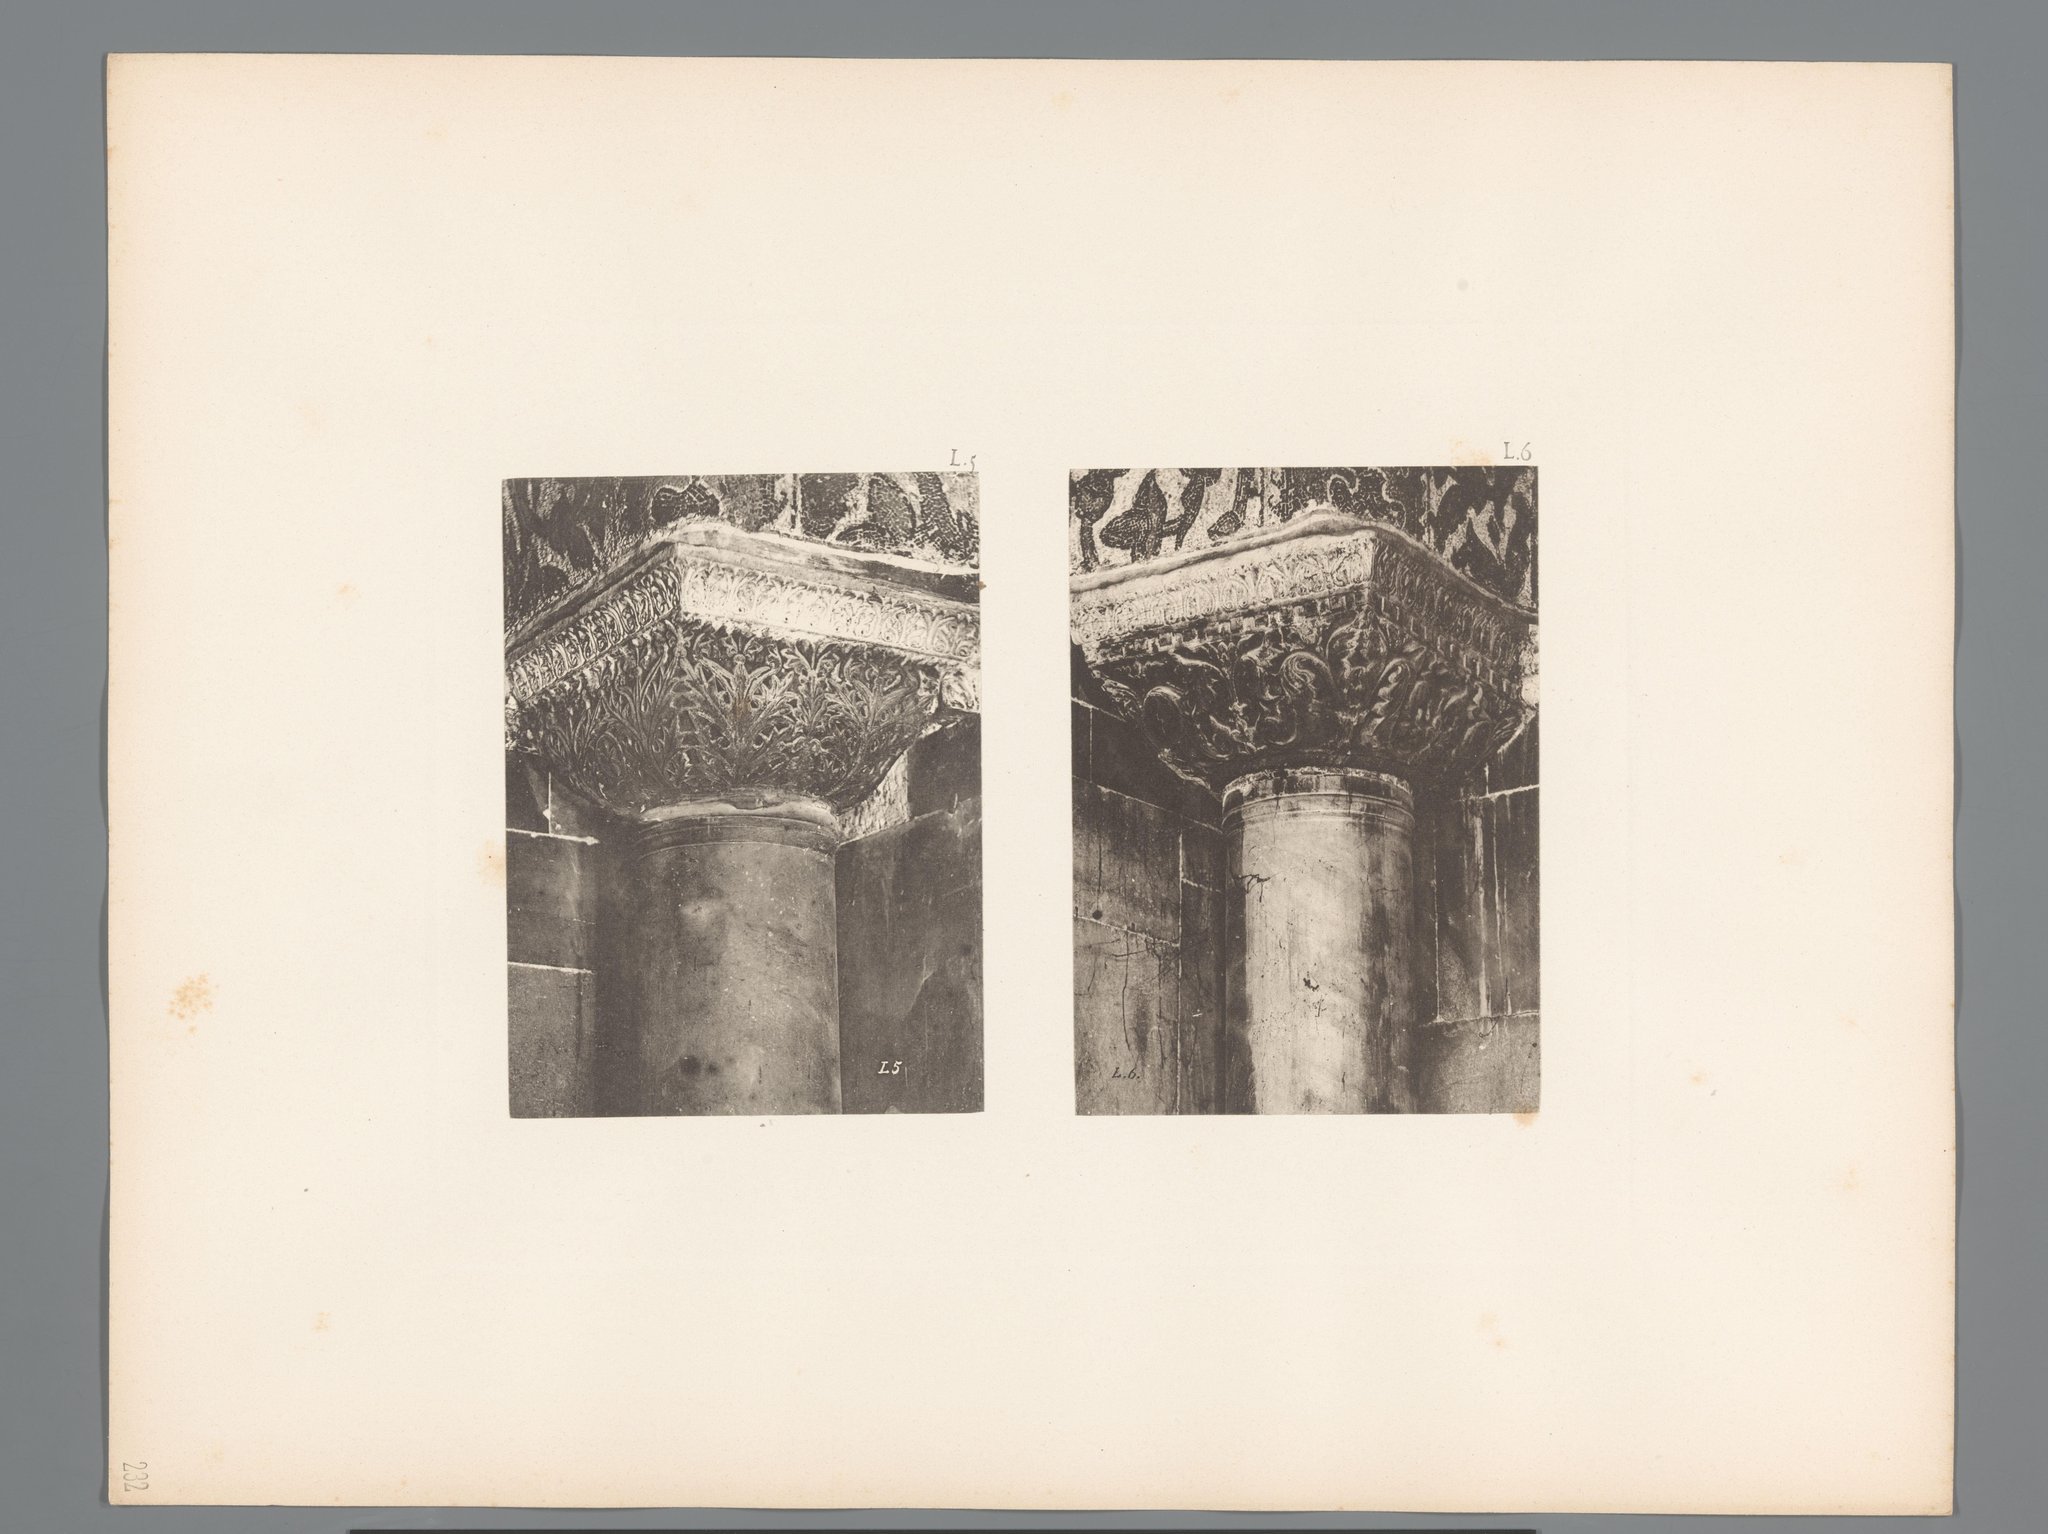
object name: photomechanical print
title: Twee afbeeldingen van kapitelen van de San Marco in Venetië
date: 1880-1885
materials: paper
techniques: photograph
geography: venice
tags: capital (~ column, pillar) (+ styles in art ~ ancient historical period), church (exterior)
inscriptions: number: ‘L.5’, number: ‘232’, number: ‘L 5’, number: ‘L.6’, number: ‘L.6.’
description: Deze prenten maken deel uit van een omslag met 79 prenten op 53 bladen en 2 tekstbladen.